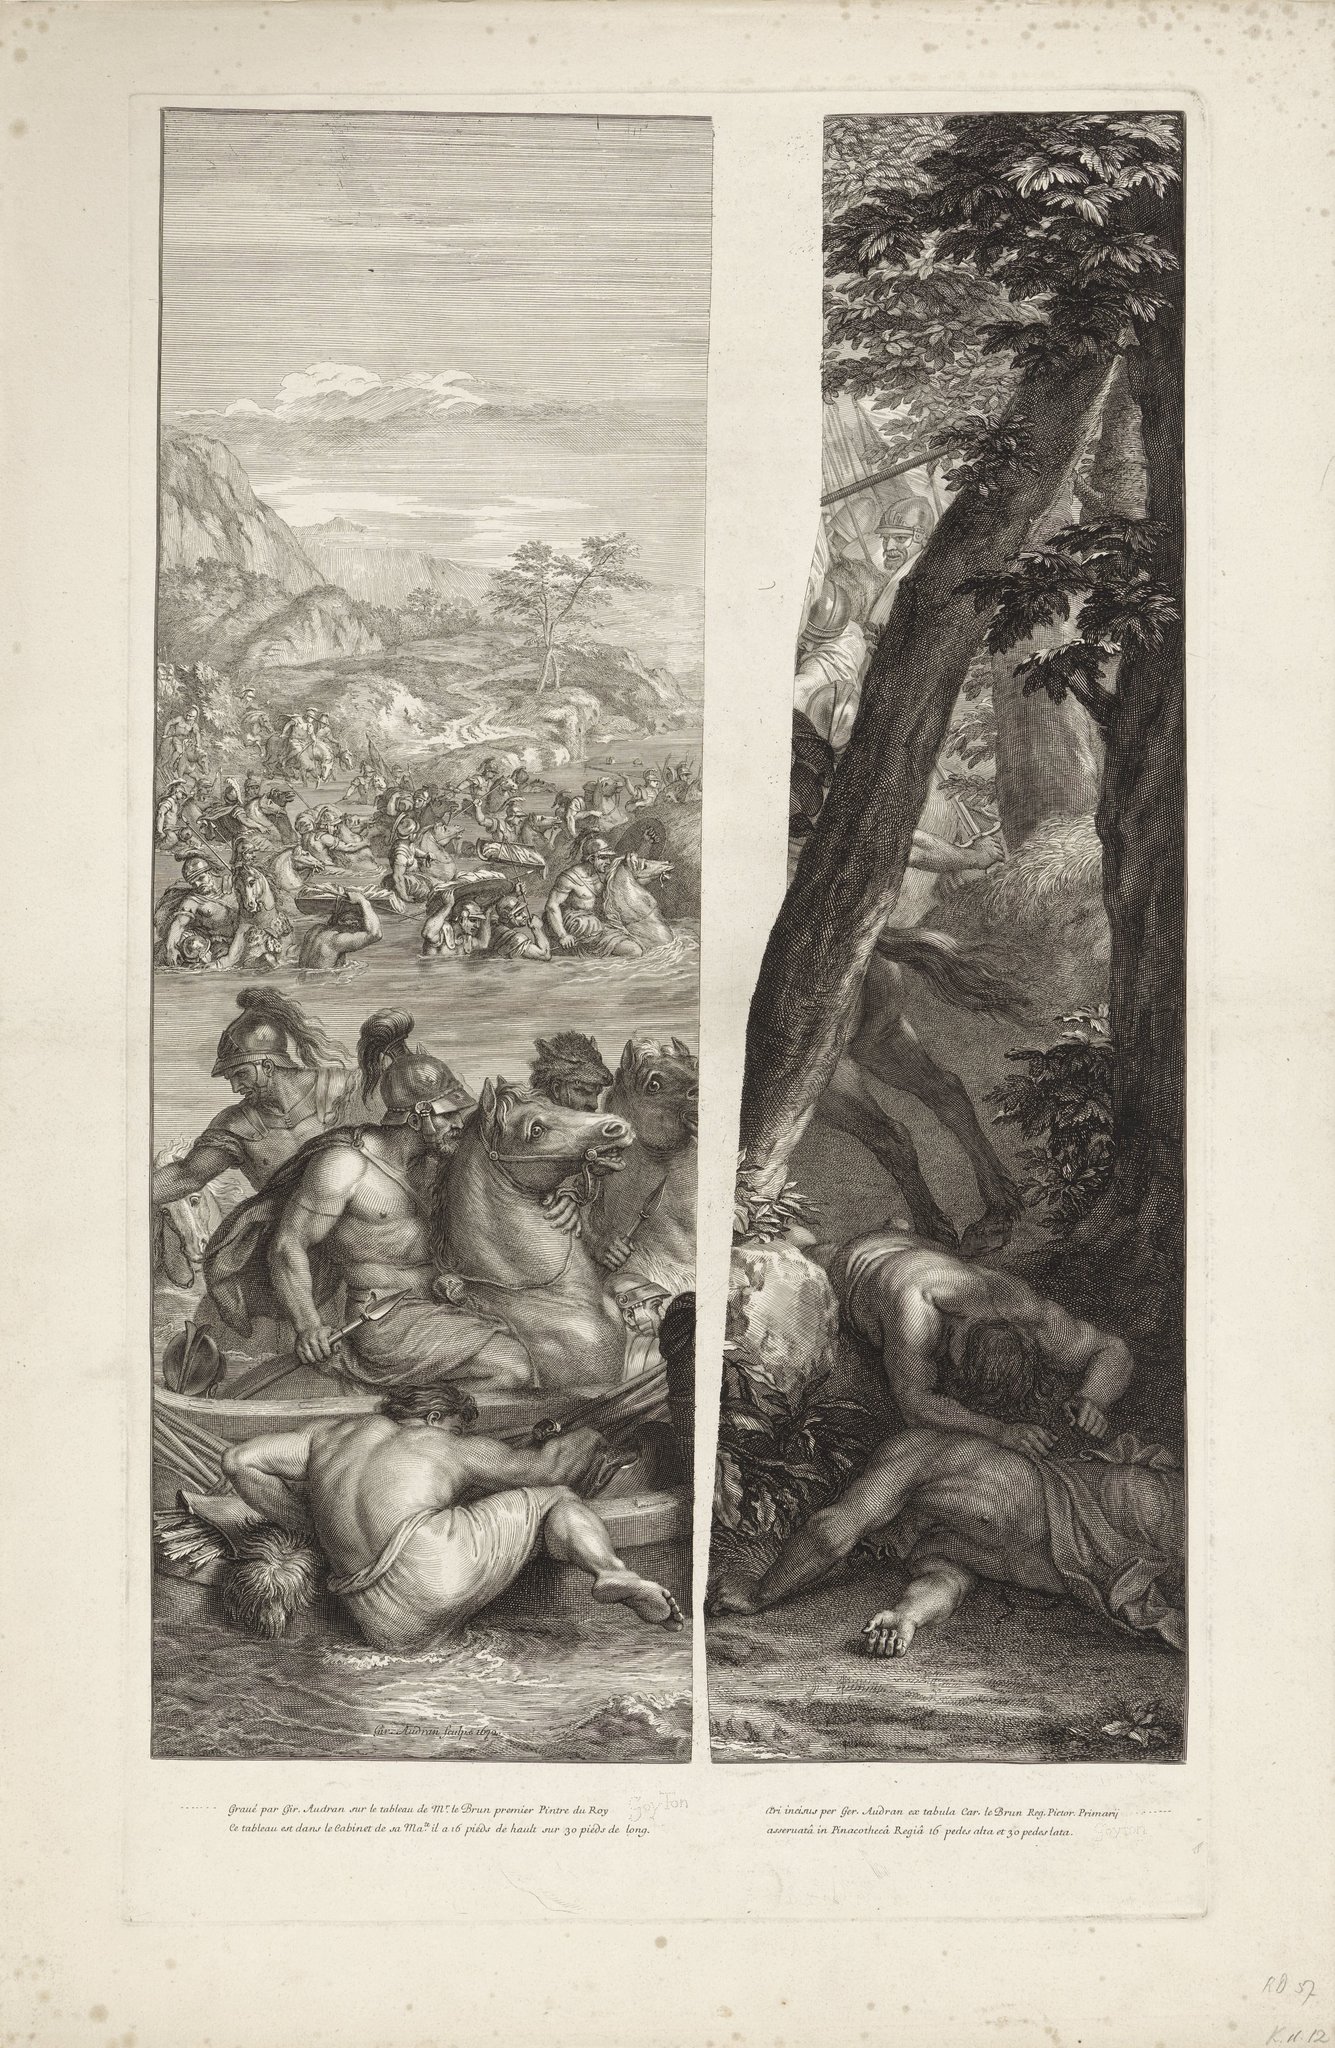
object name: print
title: Slag aan de Granicus (linker- en rechterkant)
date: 1672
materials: paper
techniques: engraving, etching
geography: paris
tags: battles of alexander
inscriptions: inscription: ‘K.d. 12’, collector's mark: Lugt 1838, inscription: ‘RD 57’, collector's mark: Lugt 240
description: Linker- en rechterkant van een prent gedrukt van drie platen.